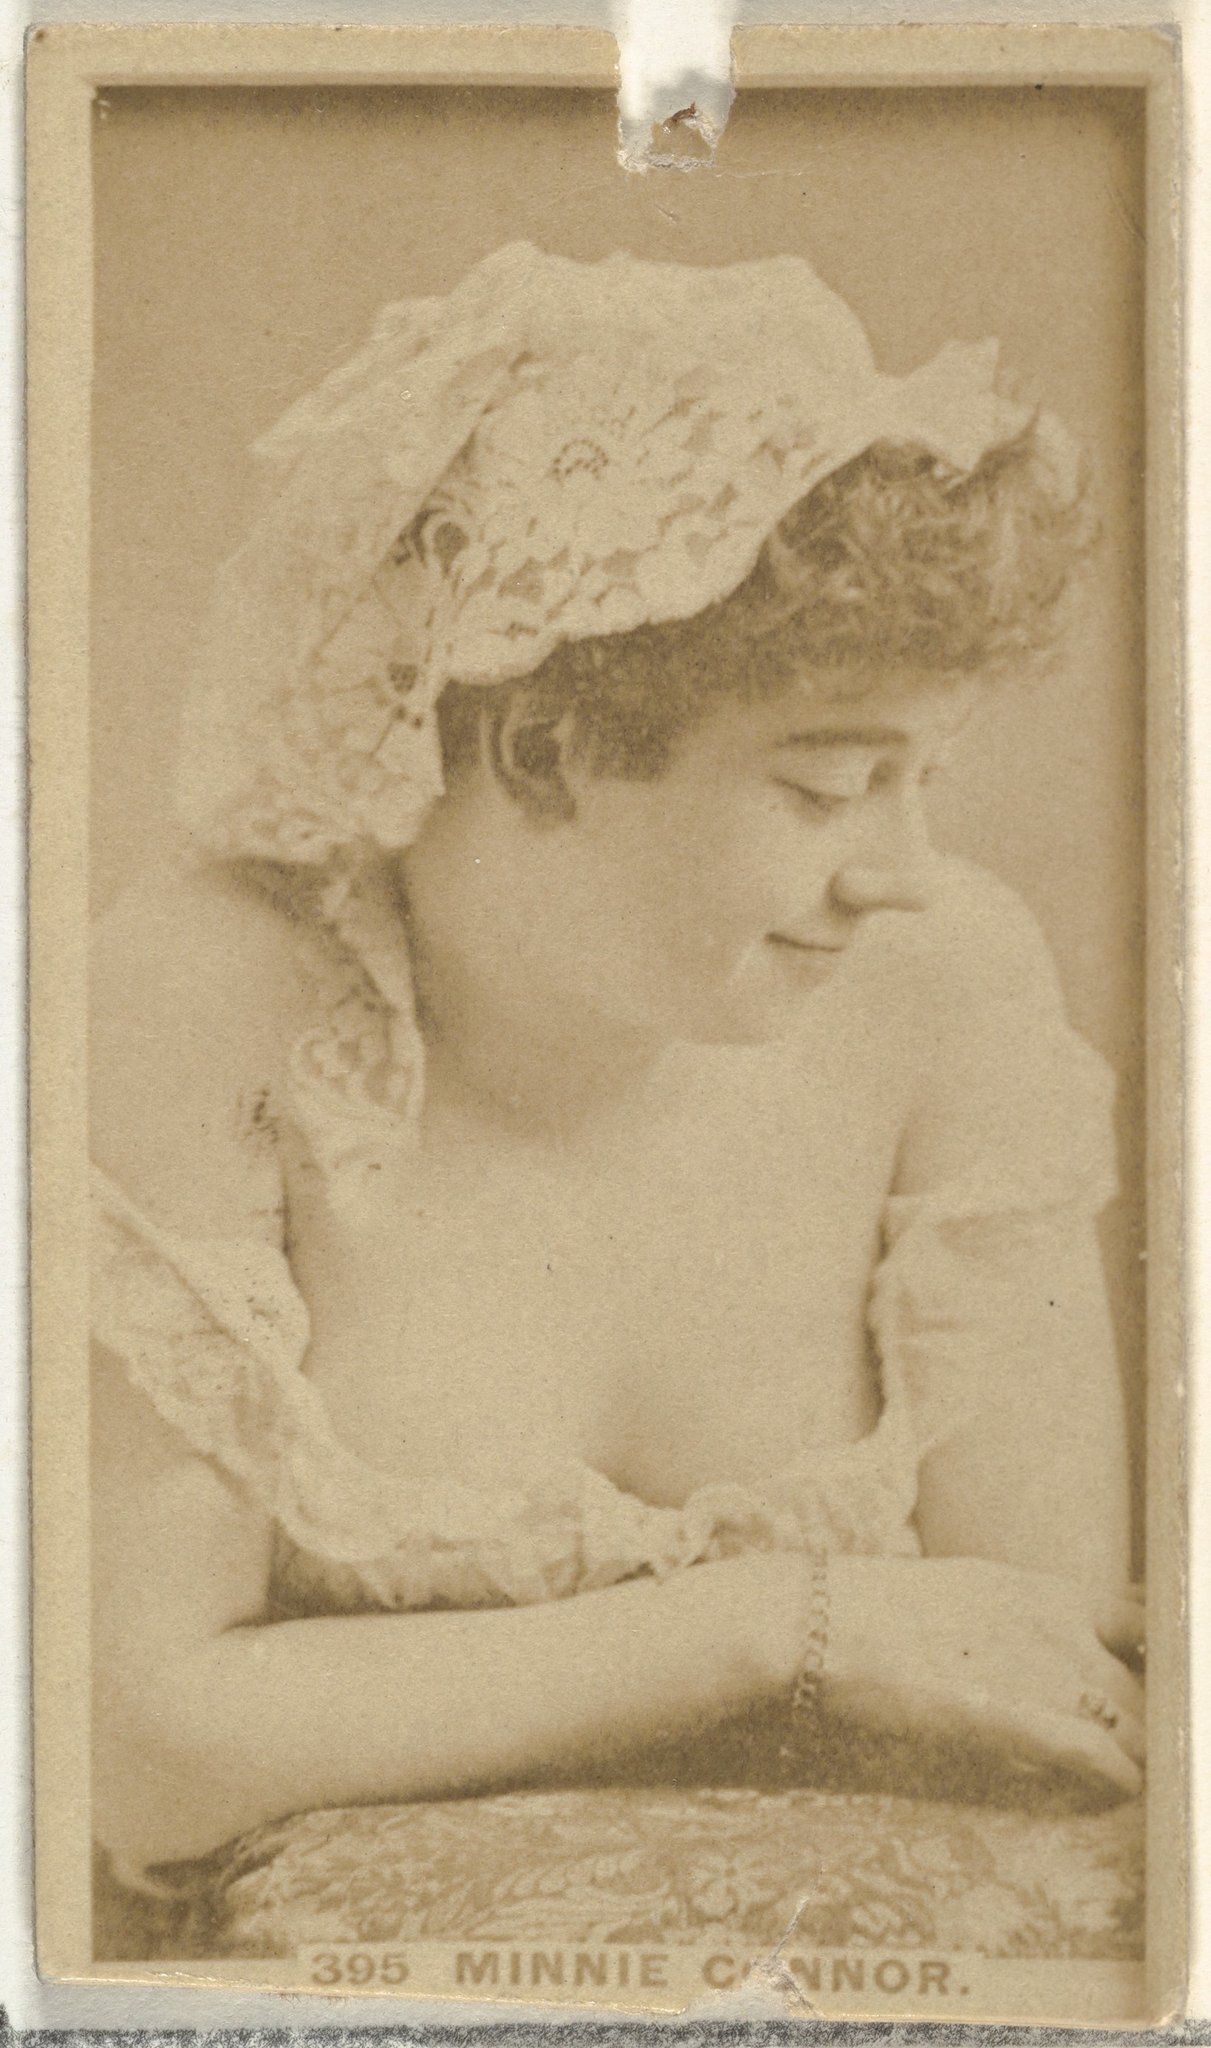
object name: photograph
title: Card Number 395, Minnie Connor, from the Actors and Actresses series (N145-7) issued by Duke Sons & Co. to promote Duke Cigarettes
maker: w. duke, sons & co.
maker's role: publisher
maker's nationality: american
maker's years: 1870-1920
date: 1880-1889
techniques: albumen silver print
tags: women,actresses